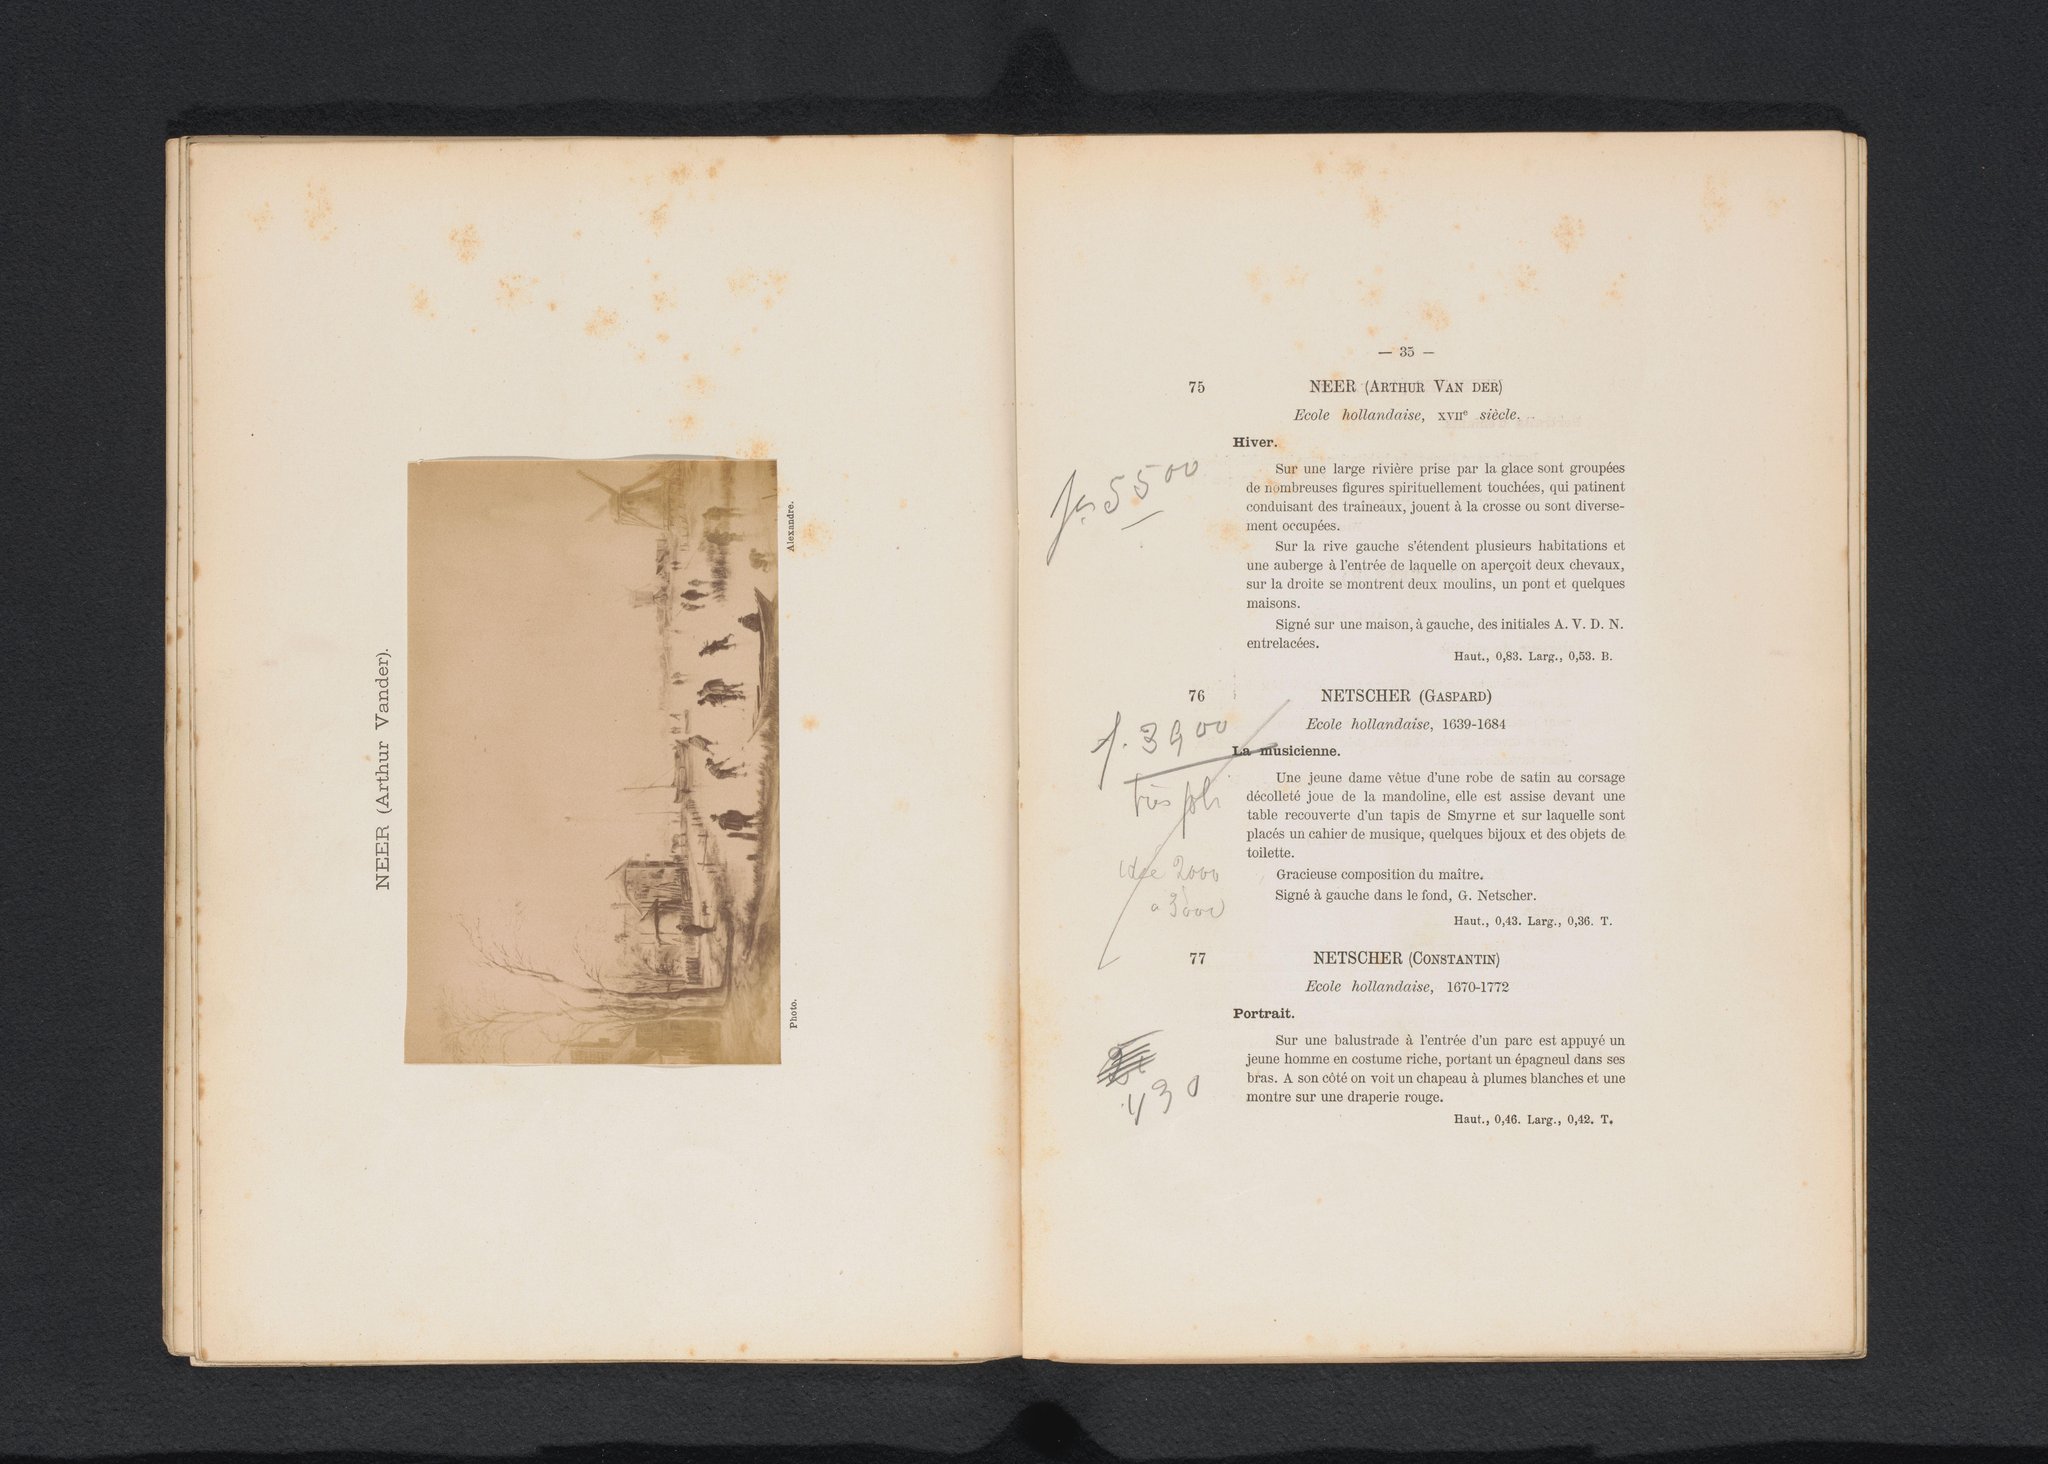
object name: reproduction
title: Fotoreproductie van een schilderij van een winterlandschap met schaatsende personen, door Aert van der Neer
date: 1886-1891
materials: photographic support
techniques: albumen print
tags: skates (winter sports) (+ sportsman, player, etc.), winter landscape; landscape symbolizing winter (the four seasons of the year)